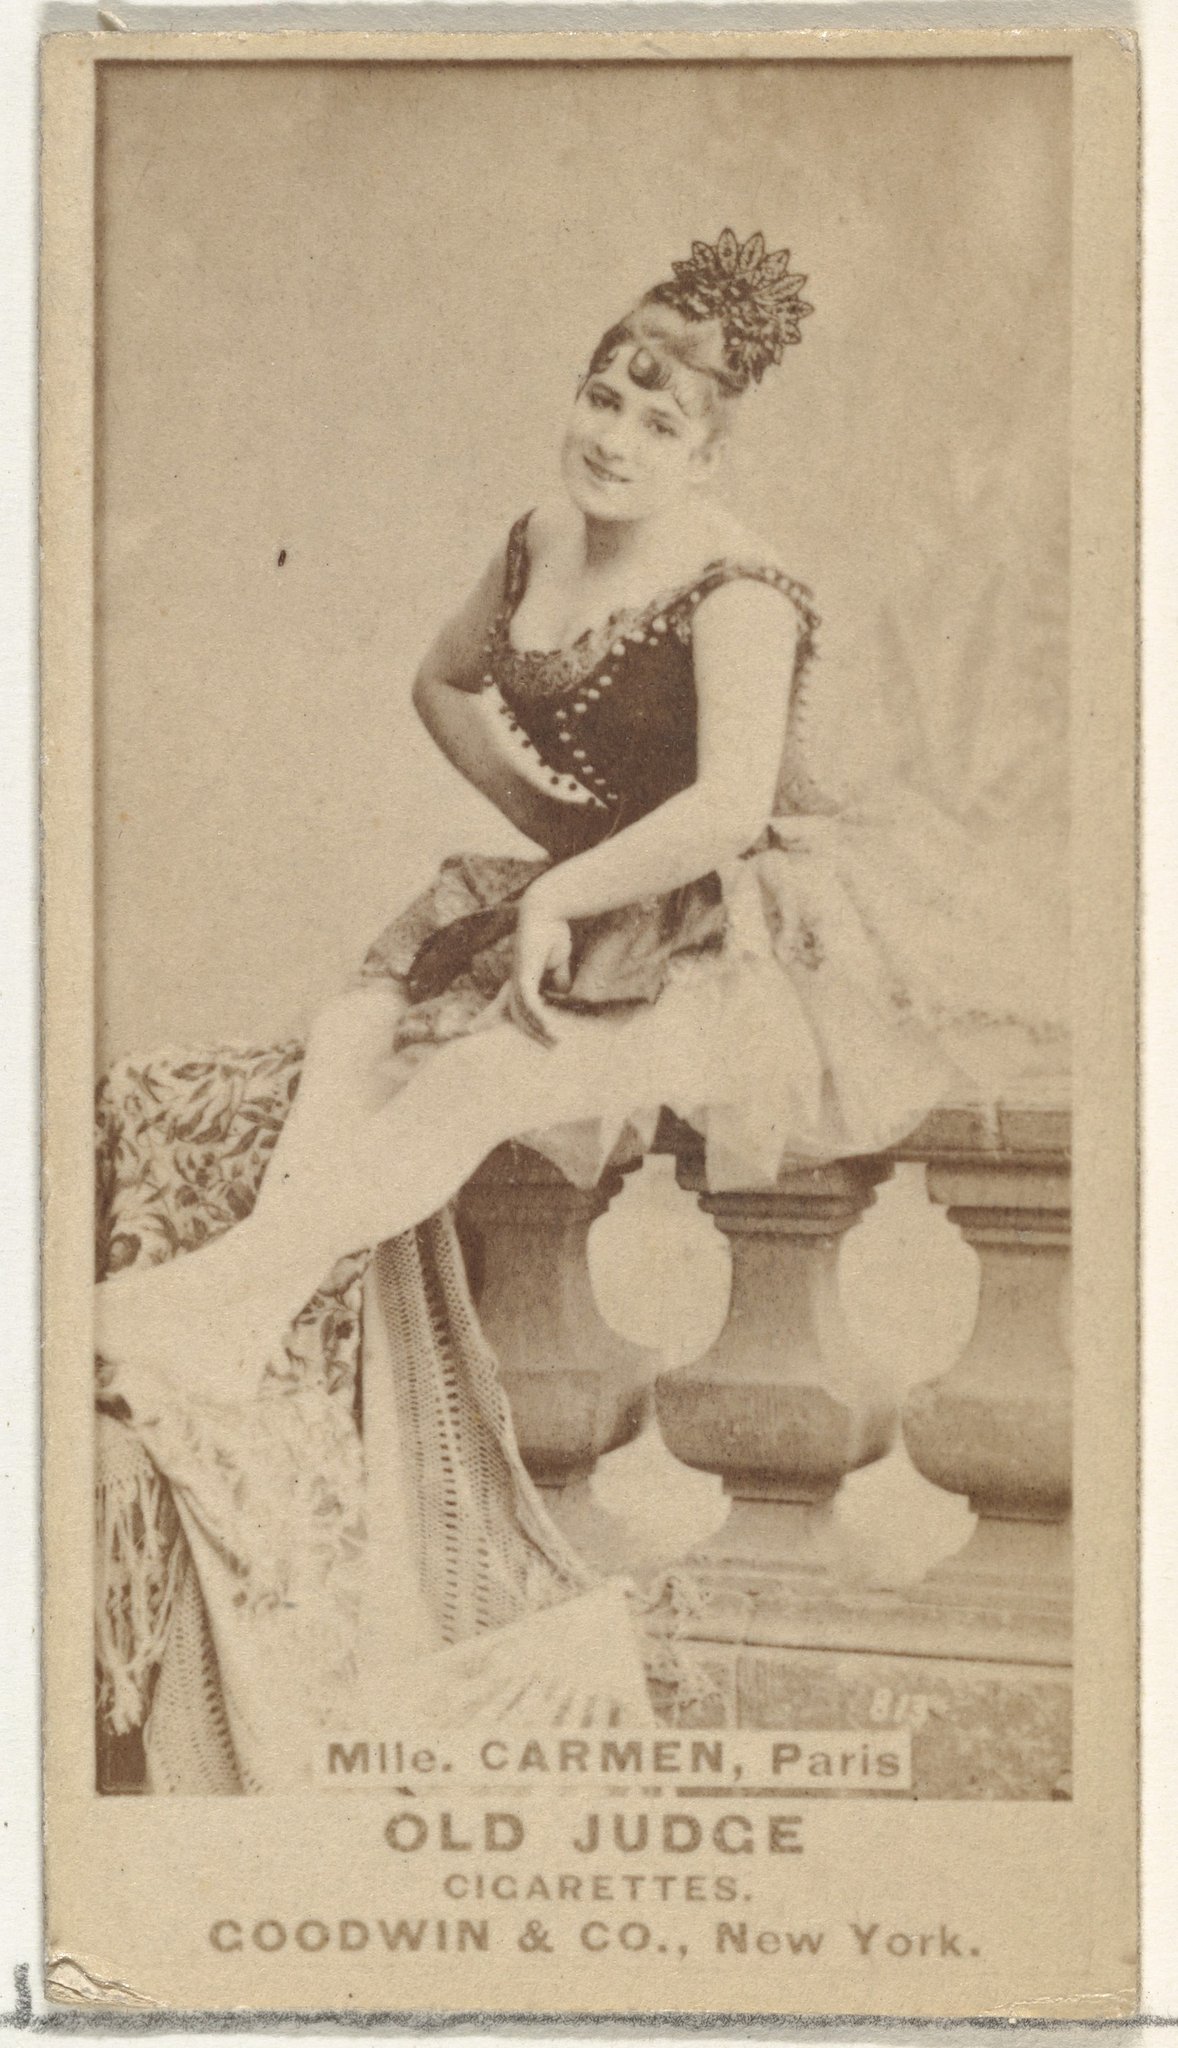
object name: photograph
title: Mlle. Carmen, Paris, from the Actors and Actresses series (N171) for Old Judge Cigarettes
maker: goodwin & company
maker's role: publisher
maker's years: 1850-1950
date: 1886-1890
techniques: albumen silver print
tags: portraits,women,actresses